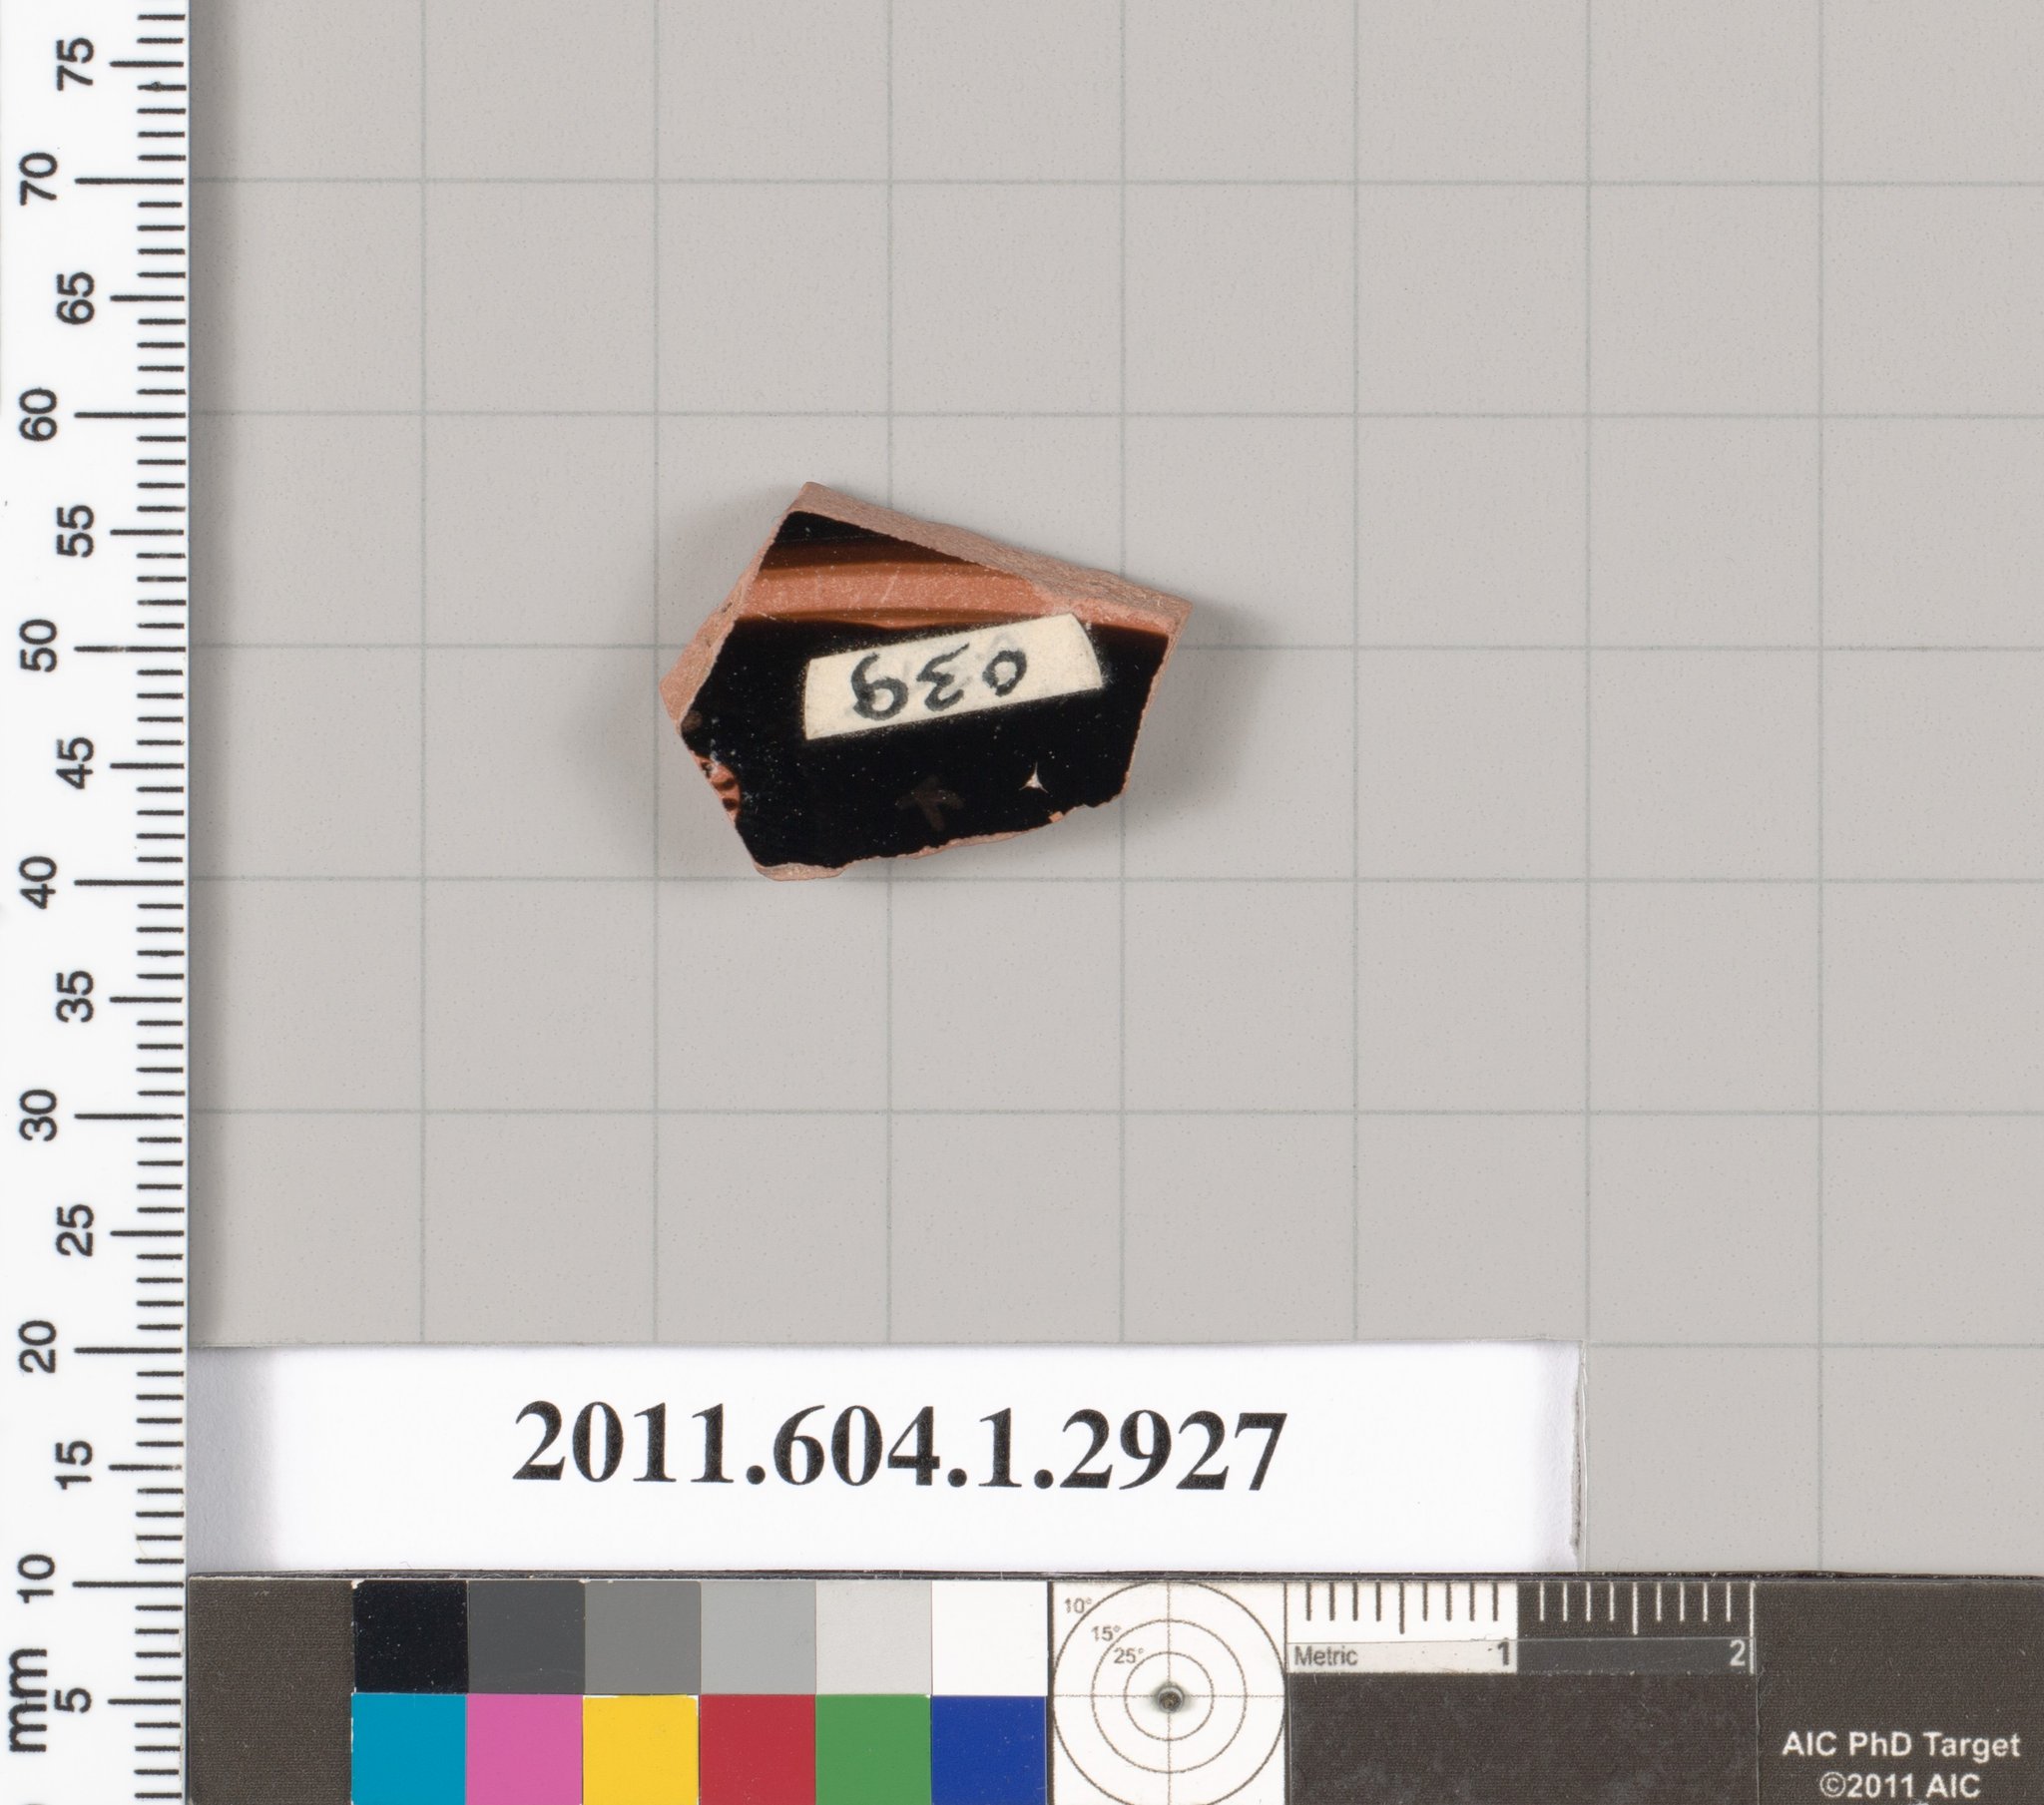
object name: kylix fragment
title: Terracotta fragment of a kylix (drinking cup)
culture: greek, attic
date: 500-480 BCE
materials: terracotta